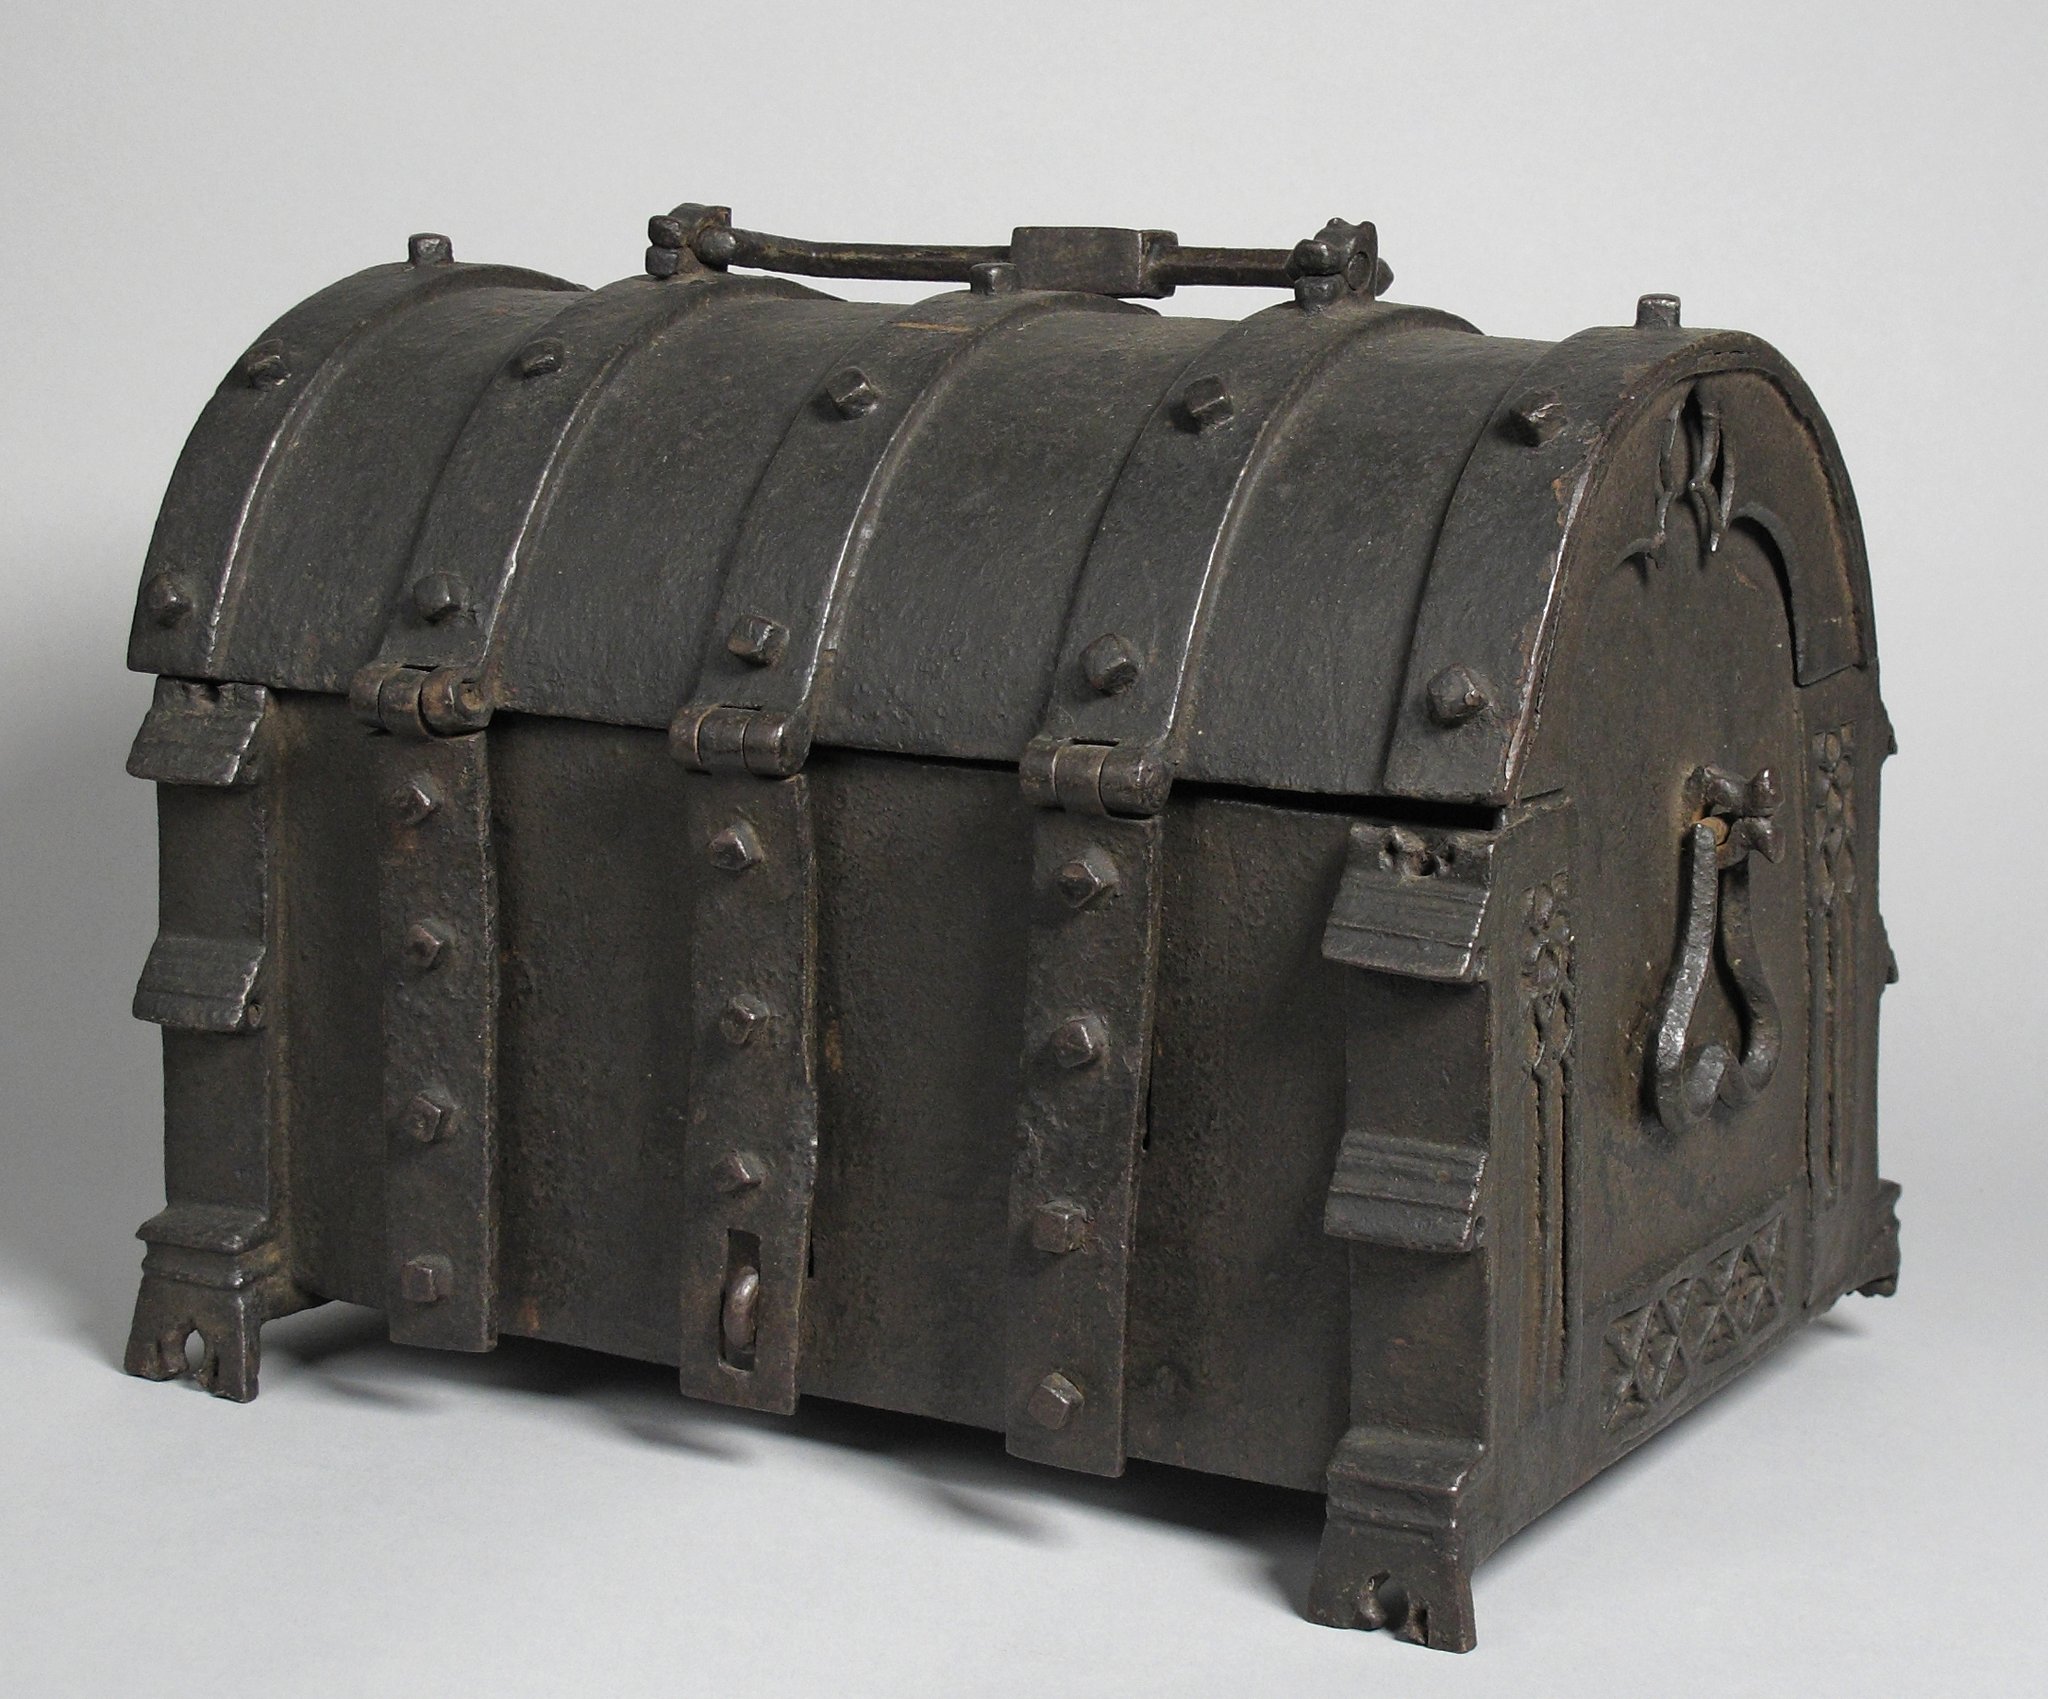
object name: chest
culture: european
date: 1401-1600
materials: iron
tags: chests